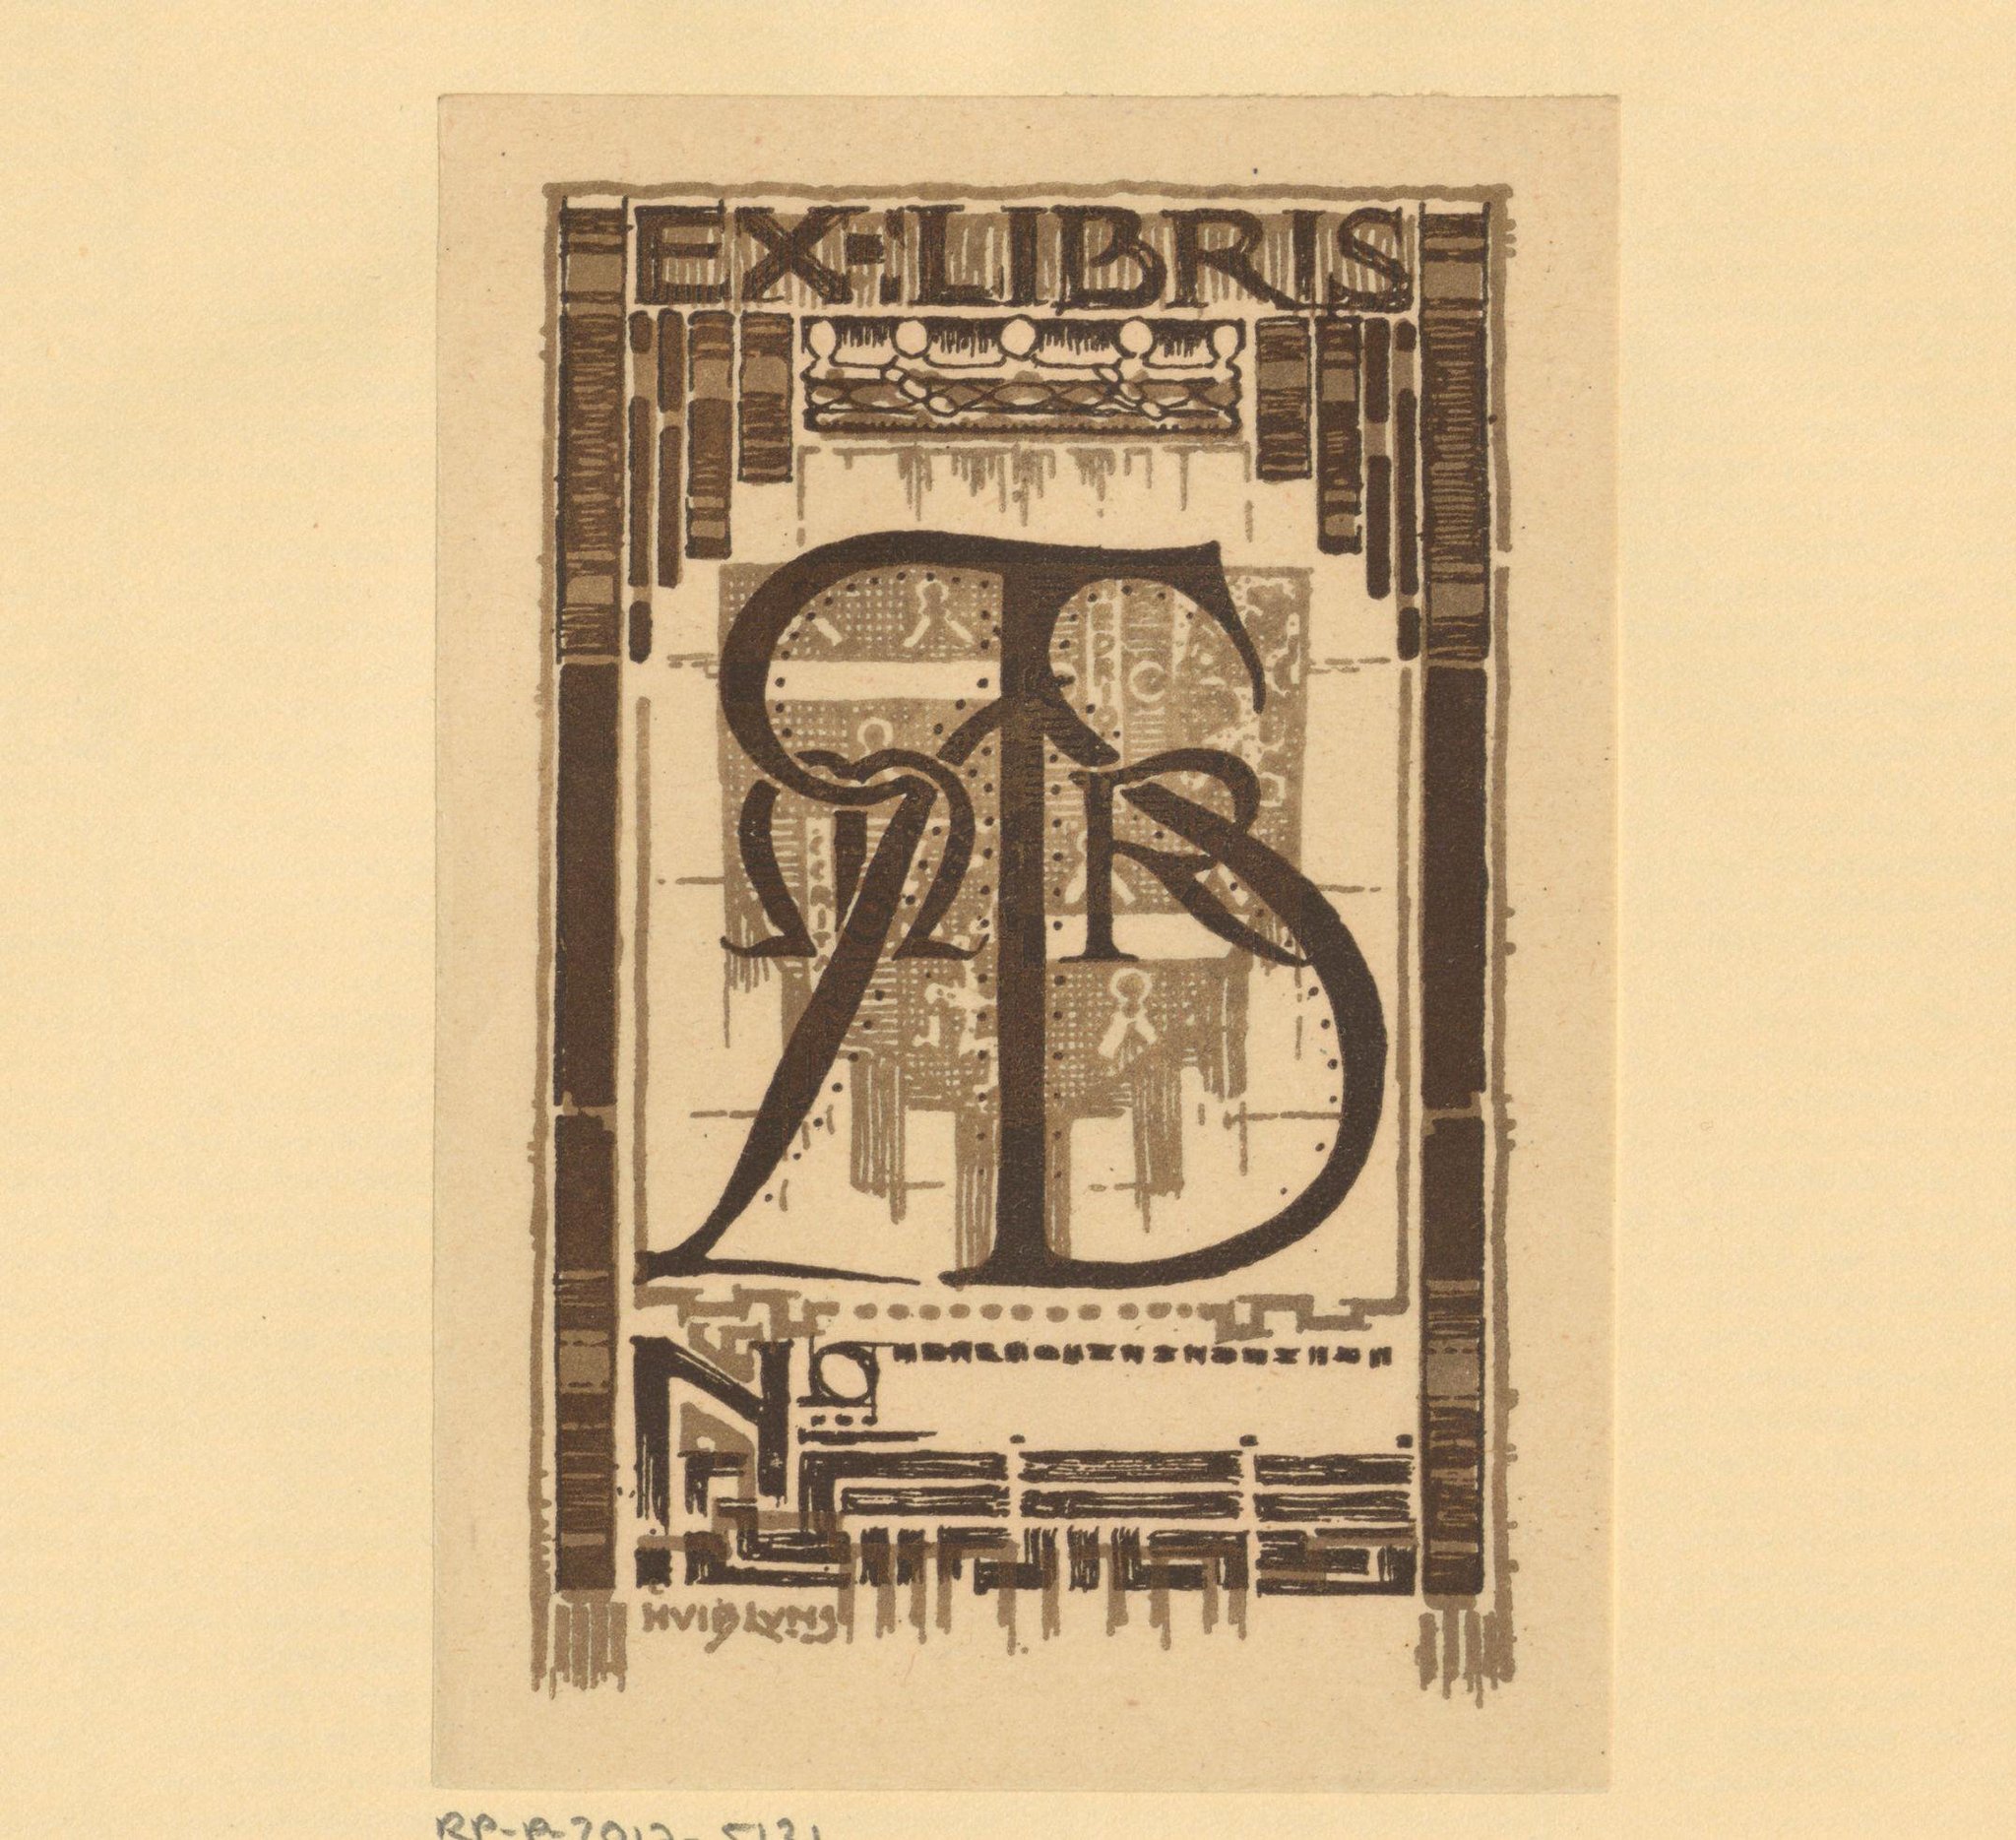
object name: bookplate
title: Ex libris van M.R.R.S.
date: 1891-1942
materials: paper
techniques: printing block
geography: netherlands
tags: utrecht, crown (symbol of sovereignty), book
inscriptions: inscription: ‘220,116 (?)’